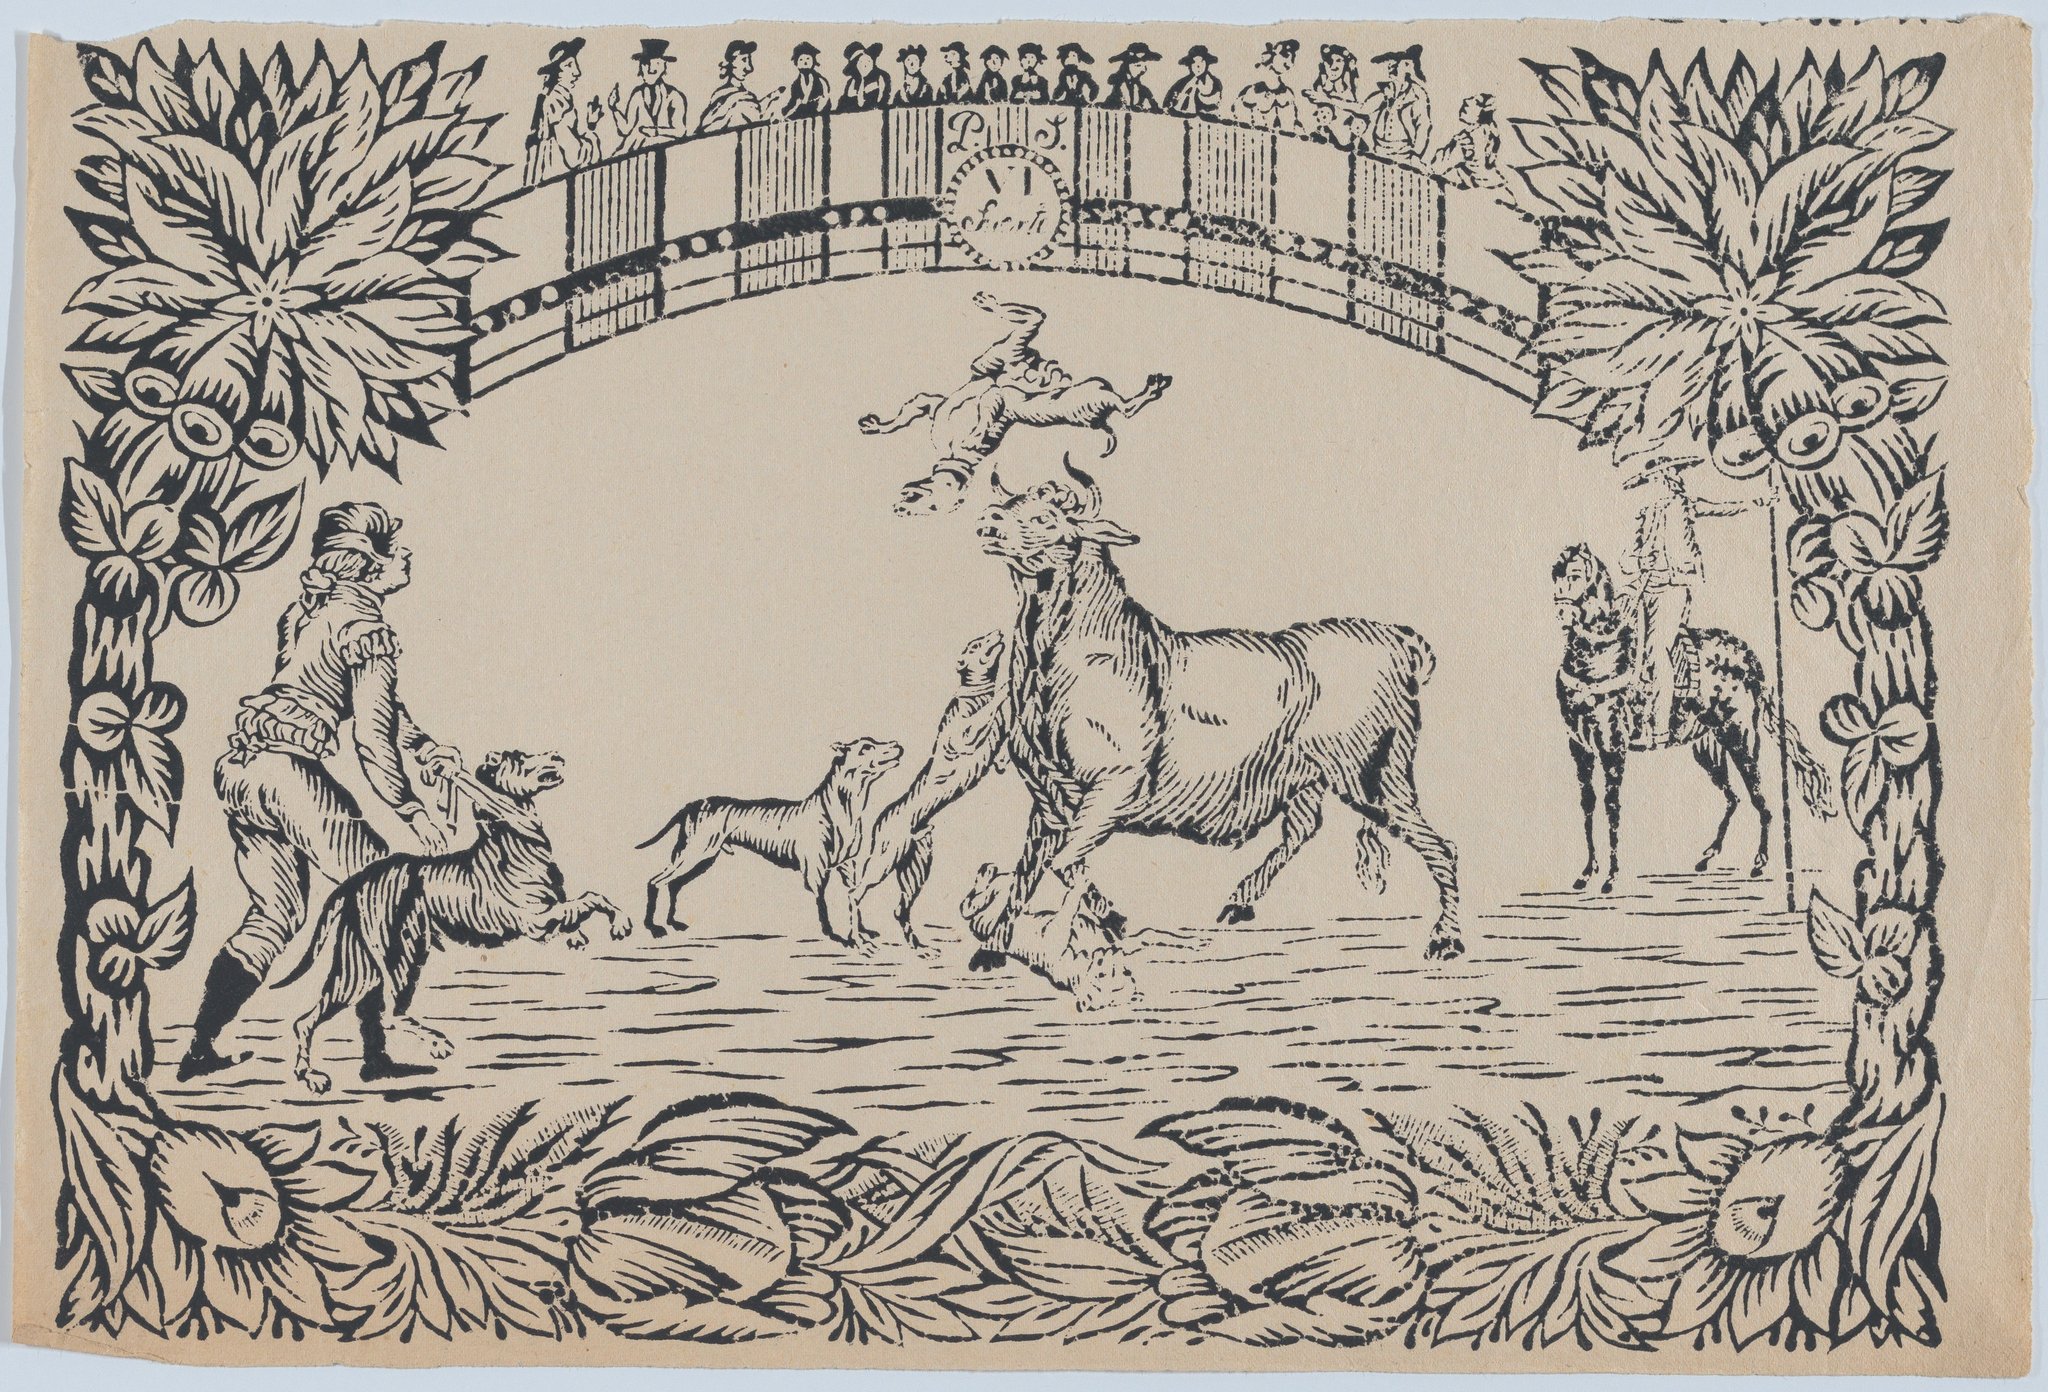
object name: print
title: Suerte VI: The torero's assistant sets dogs on the bull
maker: anonymous, spanish, 19th century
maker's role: artist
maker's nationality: spanish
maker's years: 1800-1900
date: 1850-1880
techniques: woodcut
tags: circus,bulls,dogs